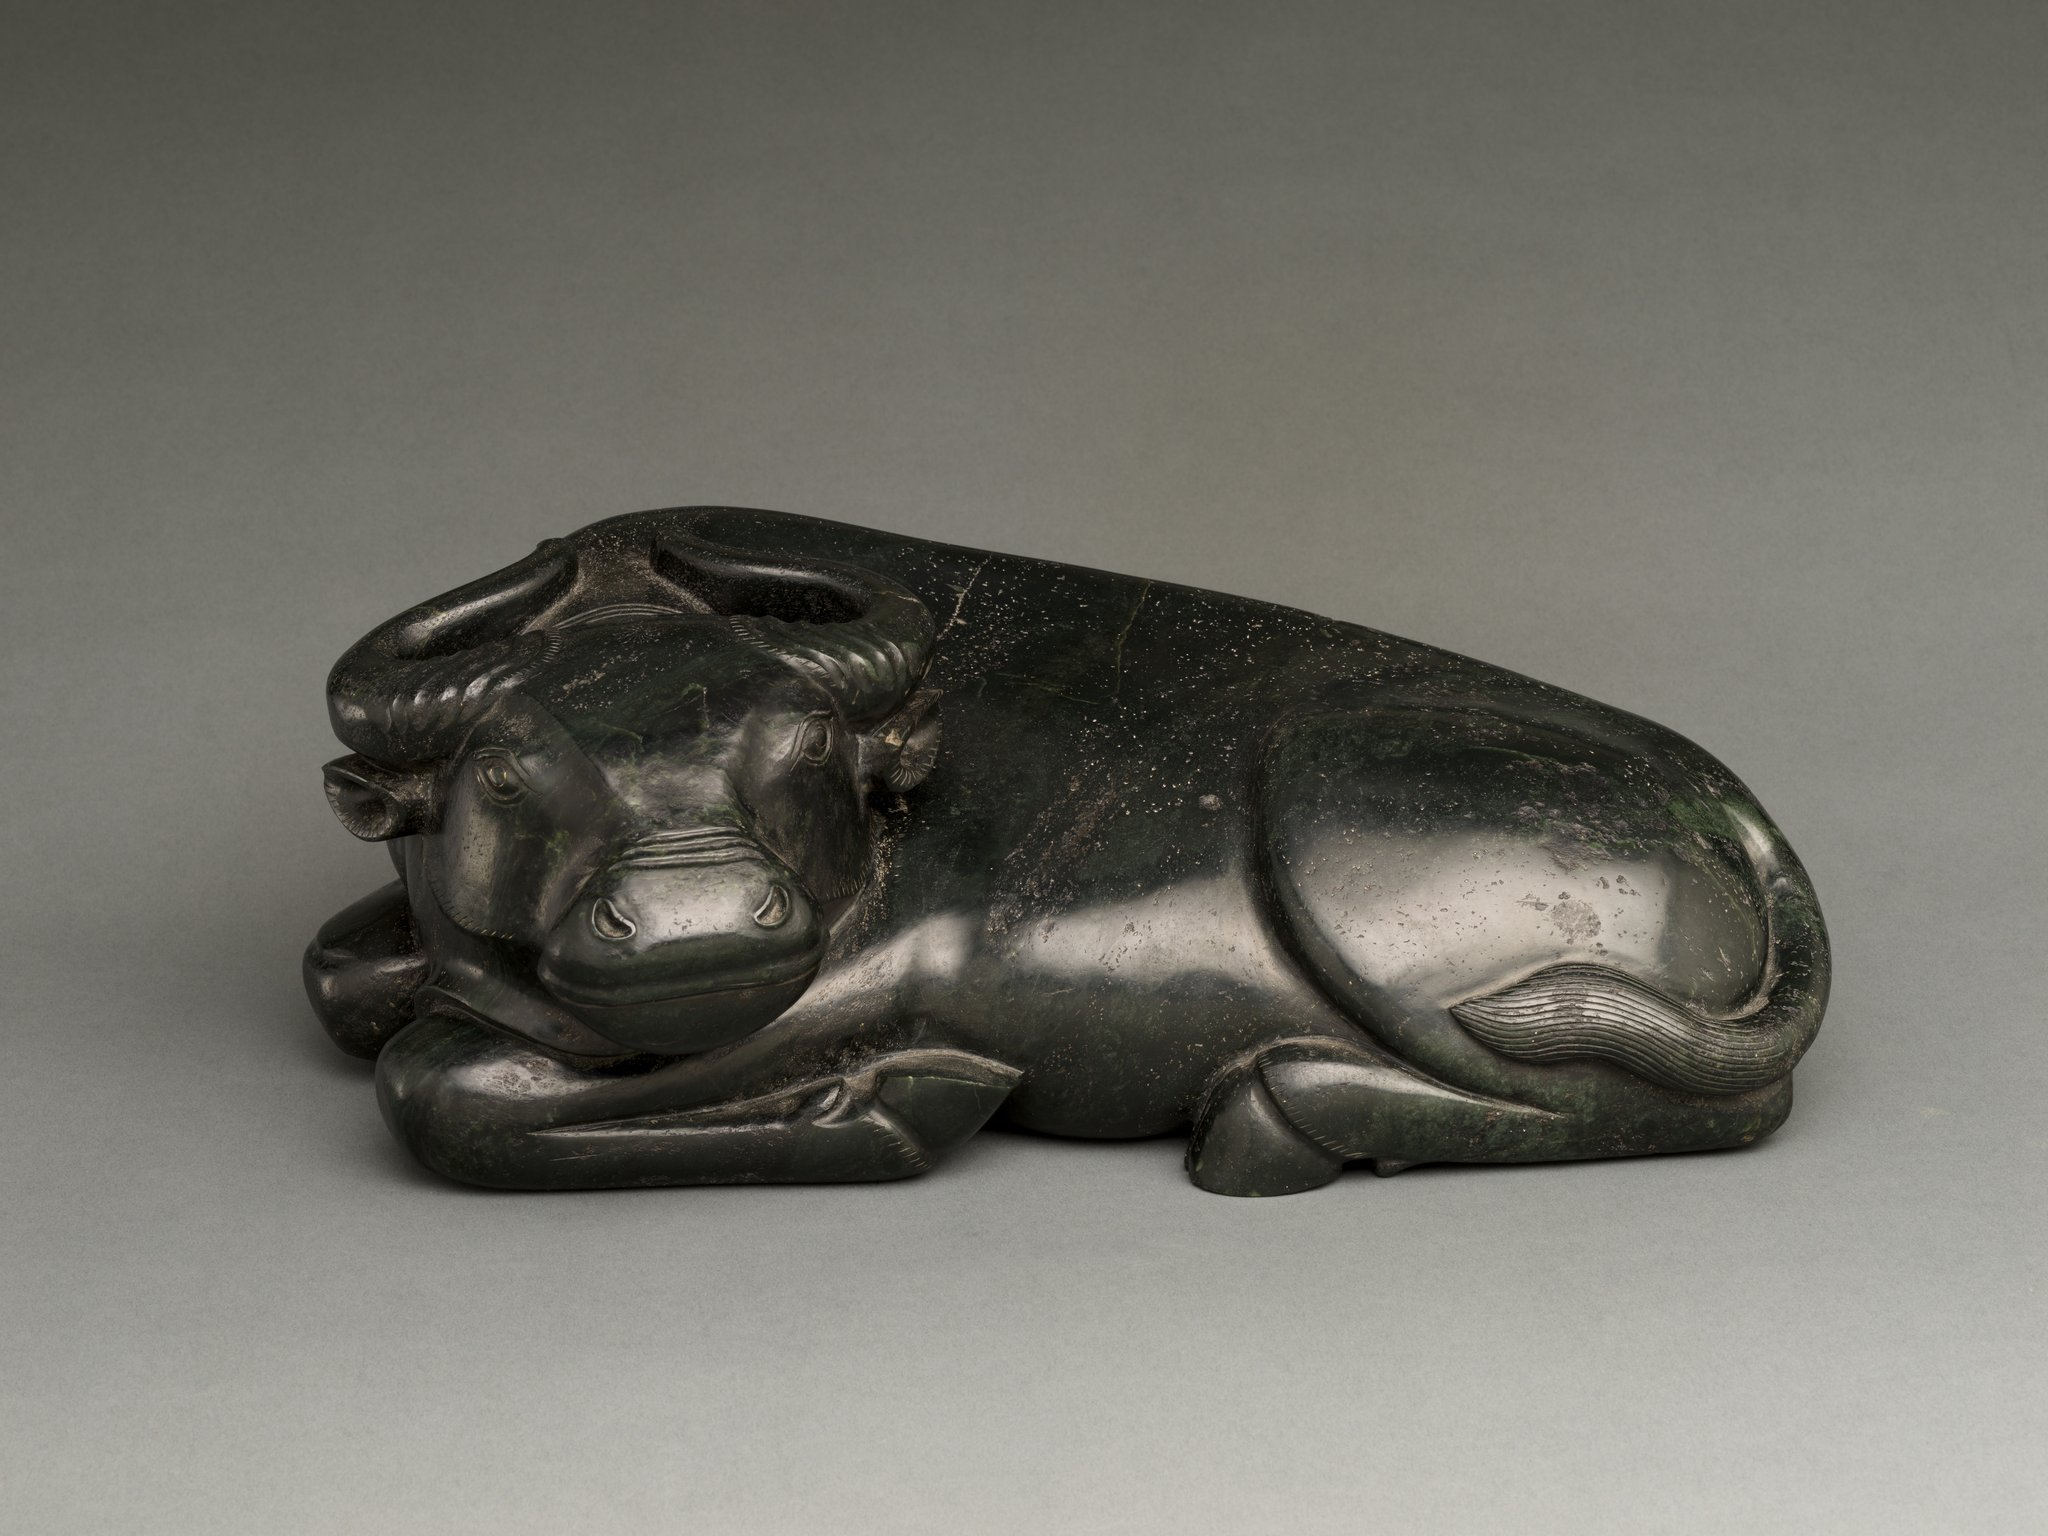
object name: figure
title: Water Buffalo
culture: chinese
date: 1701-1800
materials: jade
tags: buffalos